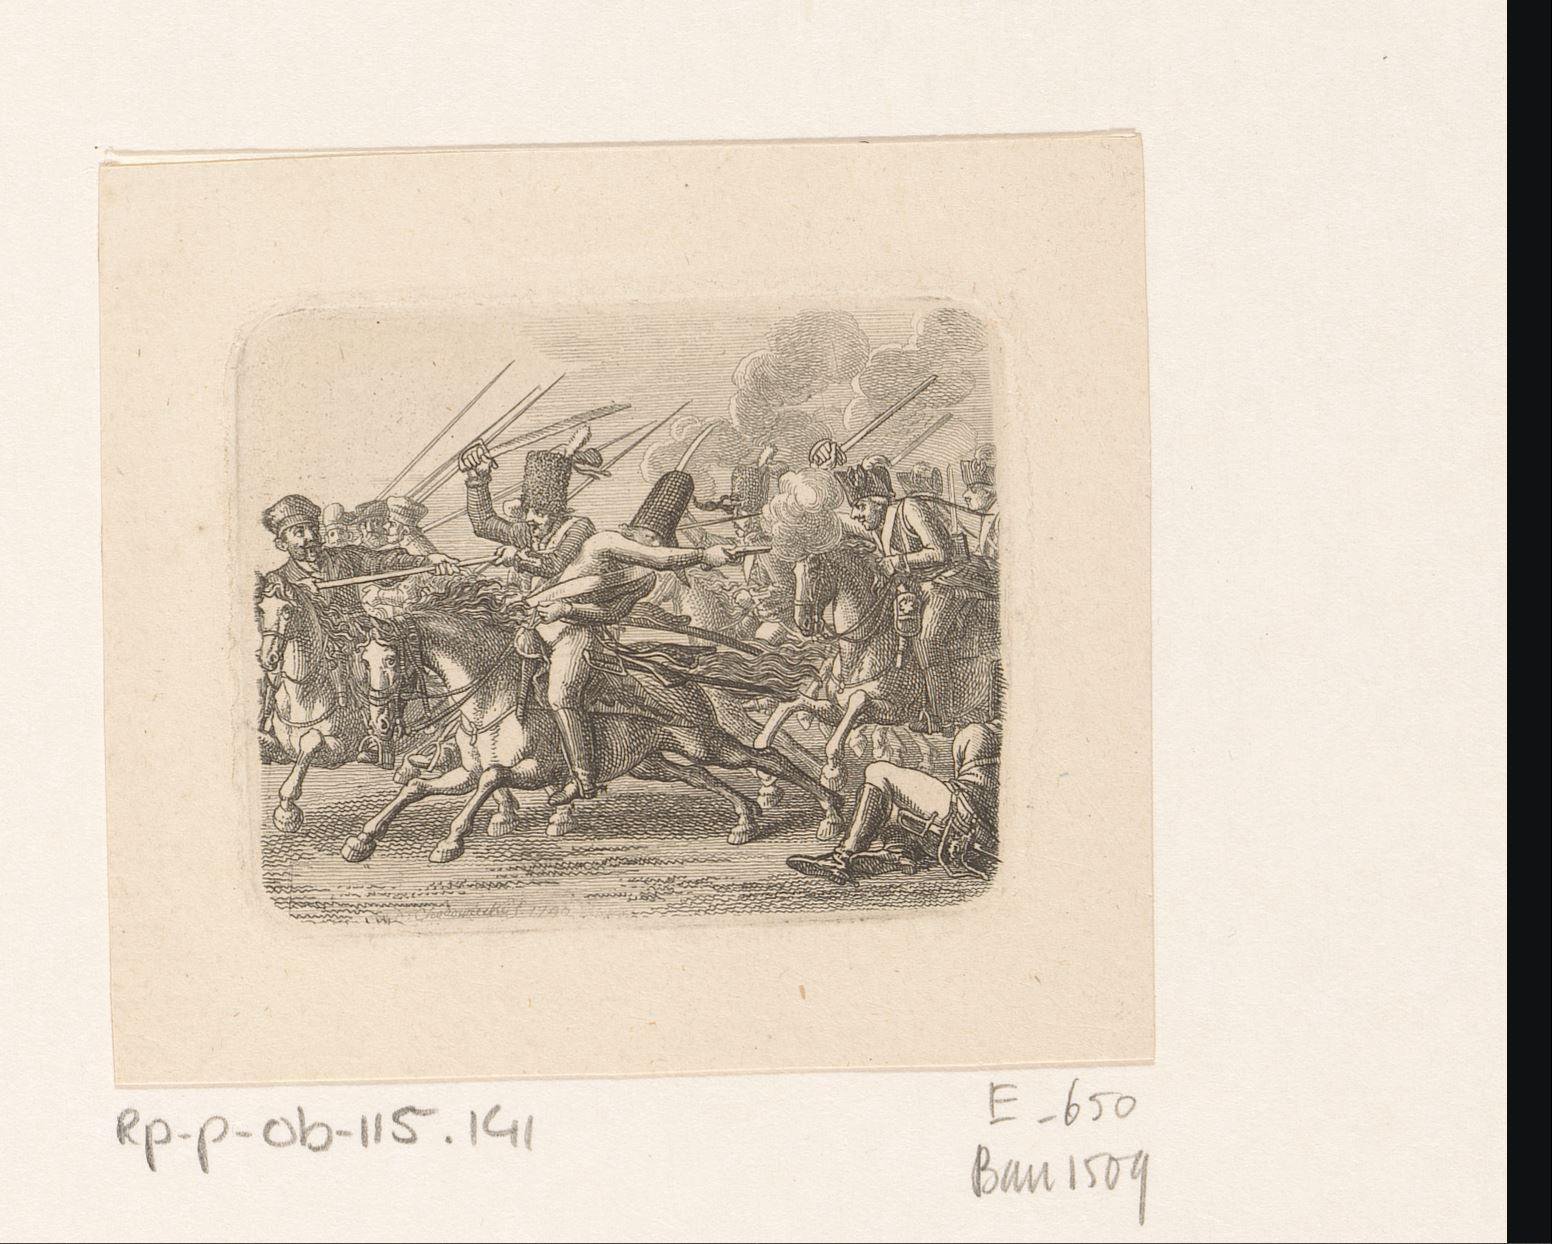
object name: print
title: Kozakken, Huzaren en Kurassiers in gevecht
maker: daniel nikolaus chodowiecki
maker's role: draughtsman, print maker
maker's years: 1726-1801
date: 1790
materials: paper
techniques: etching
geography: berlin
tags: battle, firearms (with name), europeans (with name)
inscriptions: collector's mark: Lugt 2228